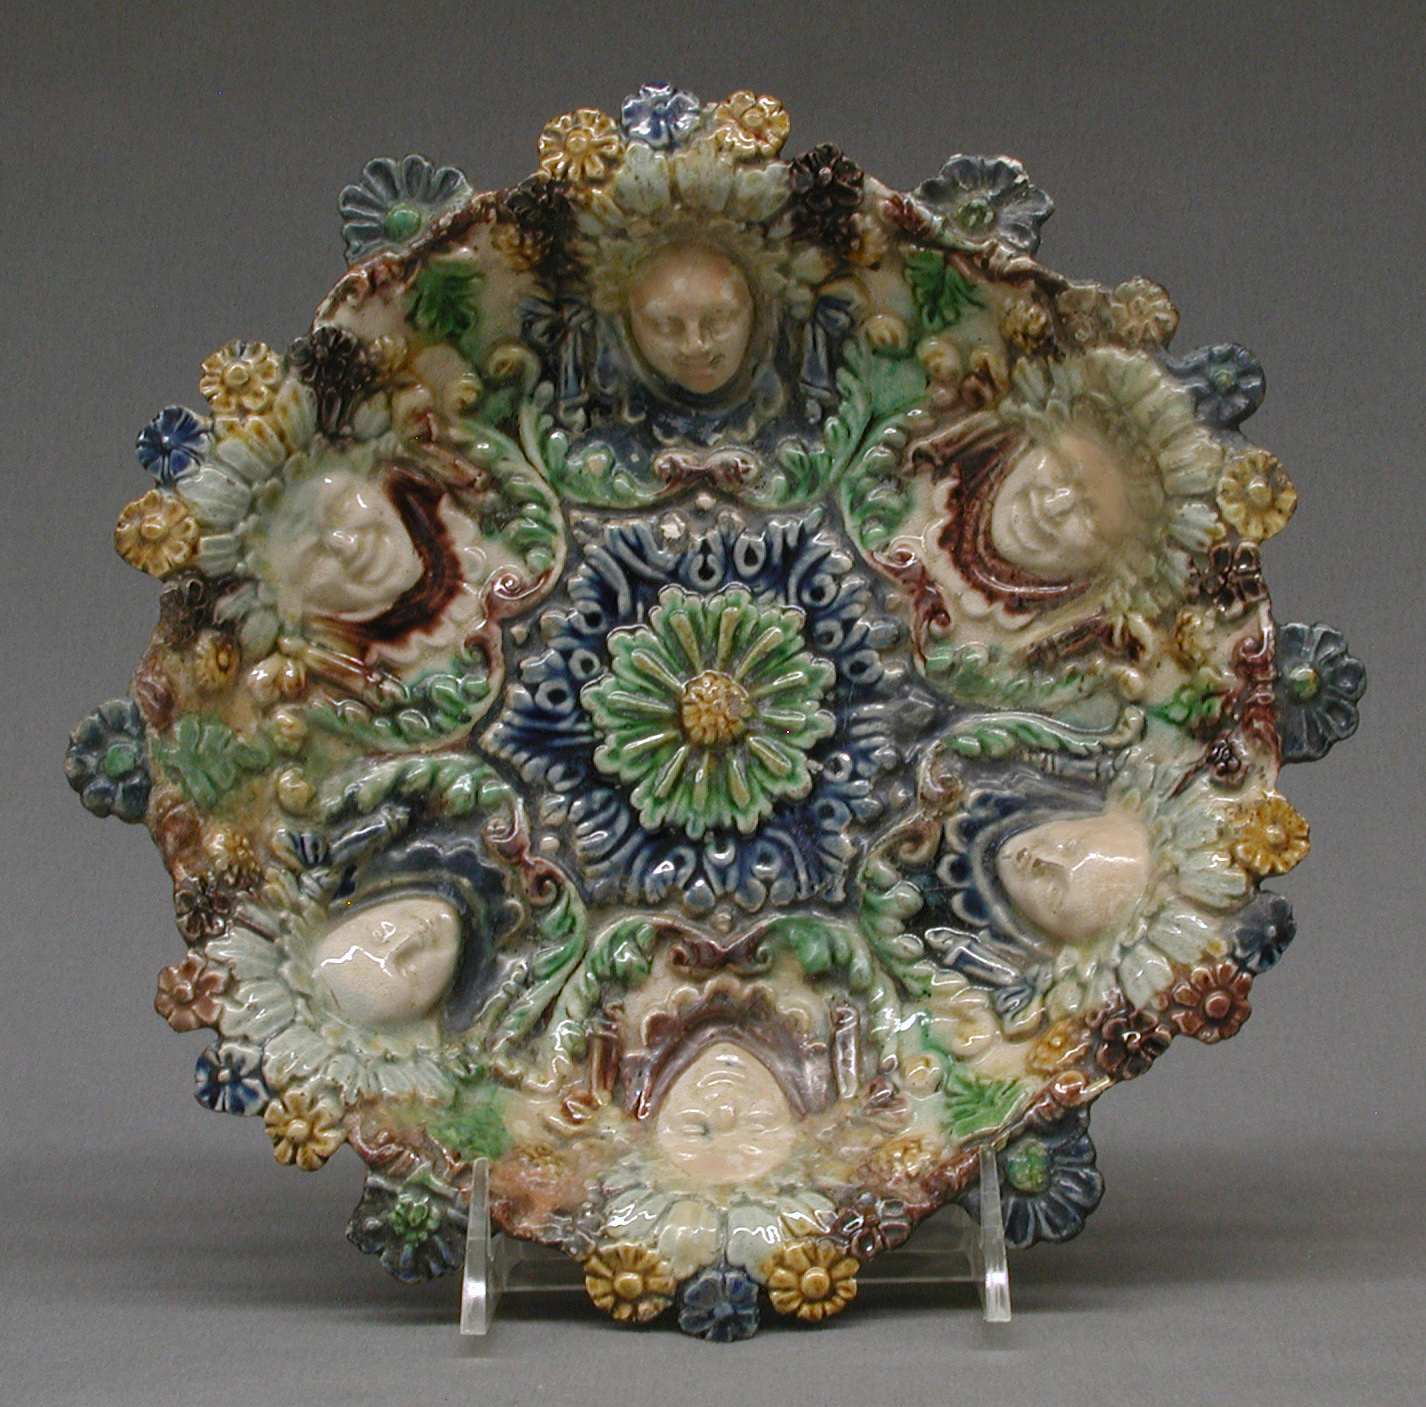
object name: dish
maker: bernard palissy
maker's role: maker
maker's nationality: french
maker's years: 1510-1590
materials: earthenware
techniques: glazing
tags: faces,flowers